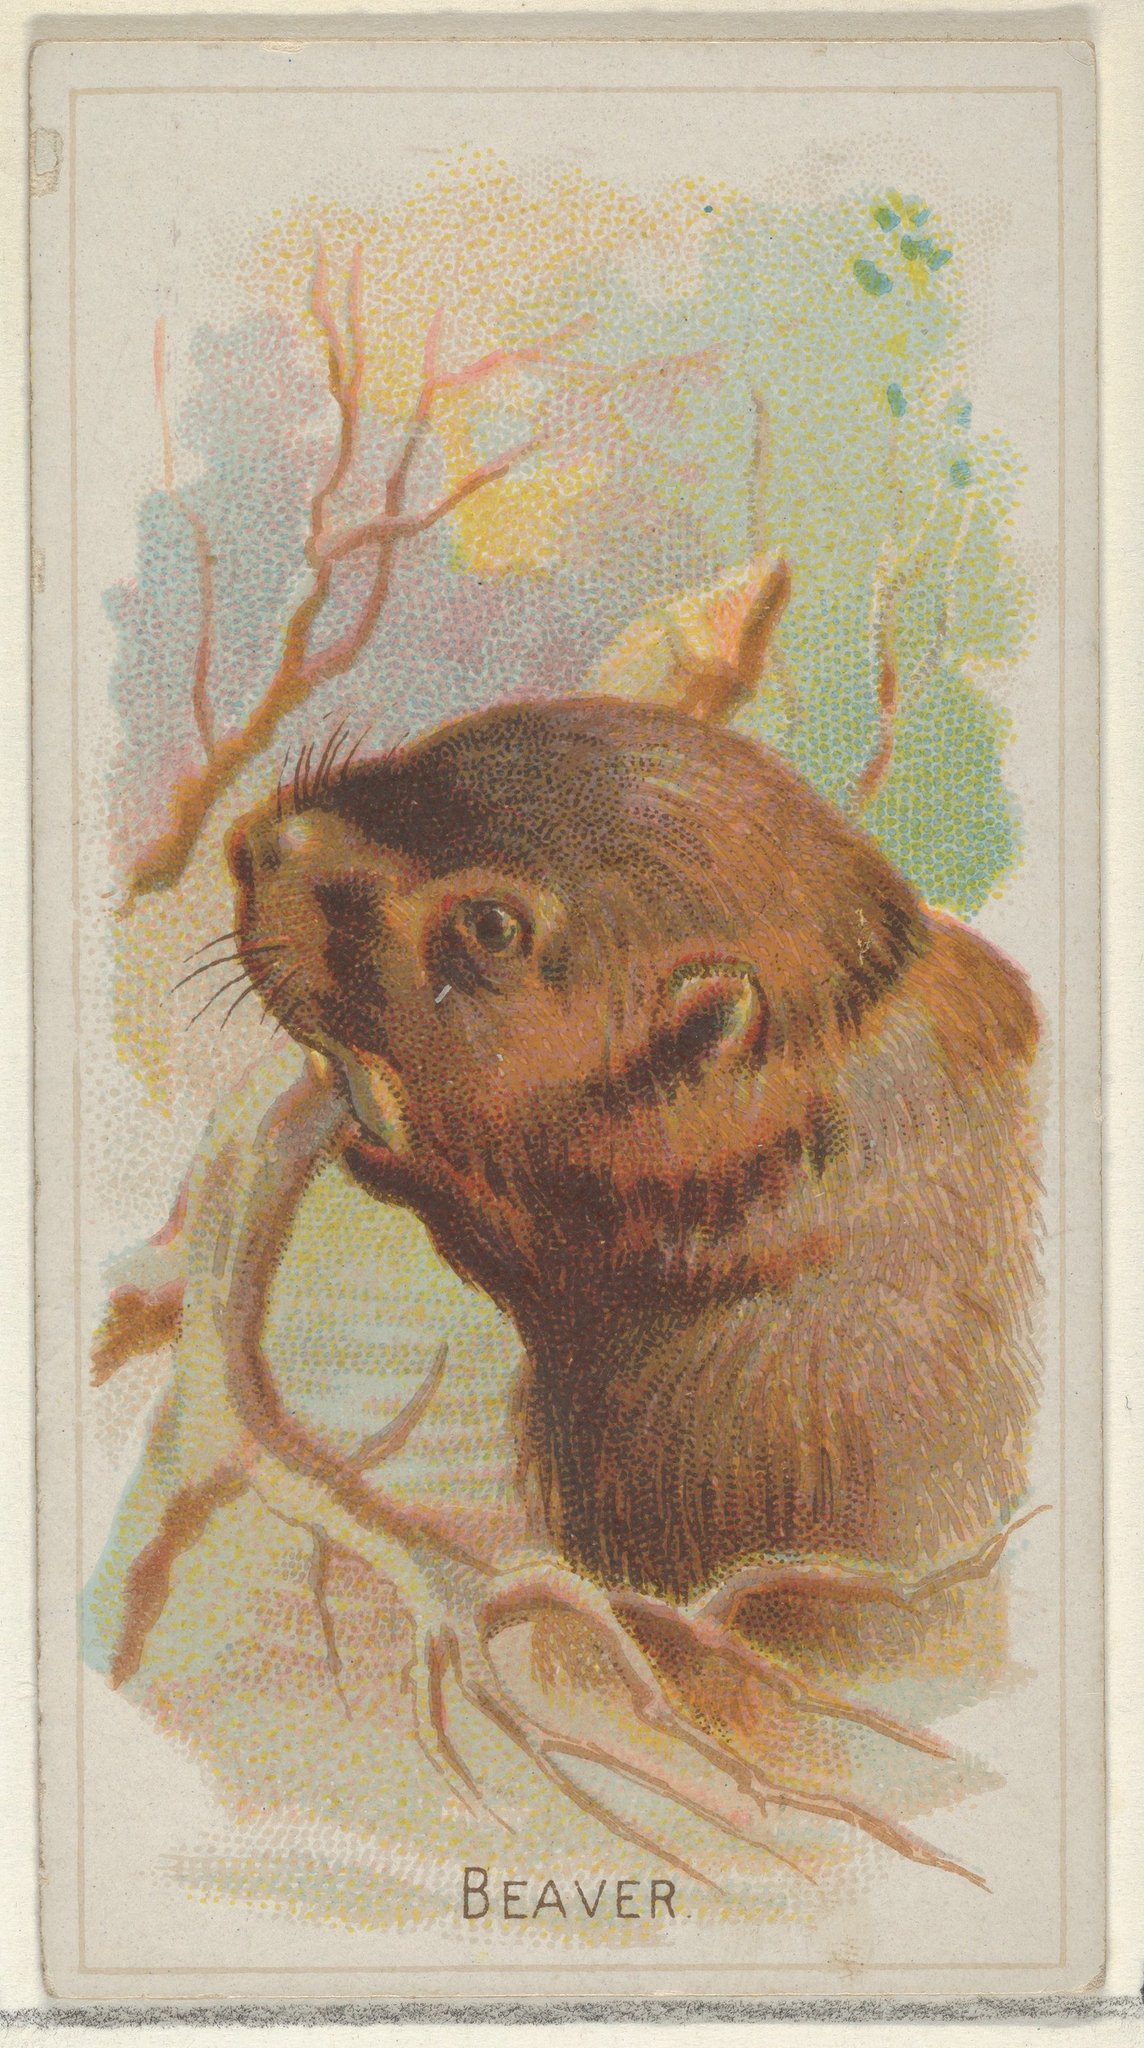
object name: print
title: Beaver, from the Wild Animals of the World series (N25) for Allen & Ginter Cigarettes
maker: allen & ginter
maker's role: publisher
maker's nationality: american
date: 1888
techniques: color lithograph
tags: animals